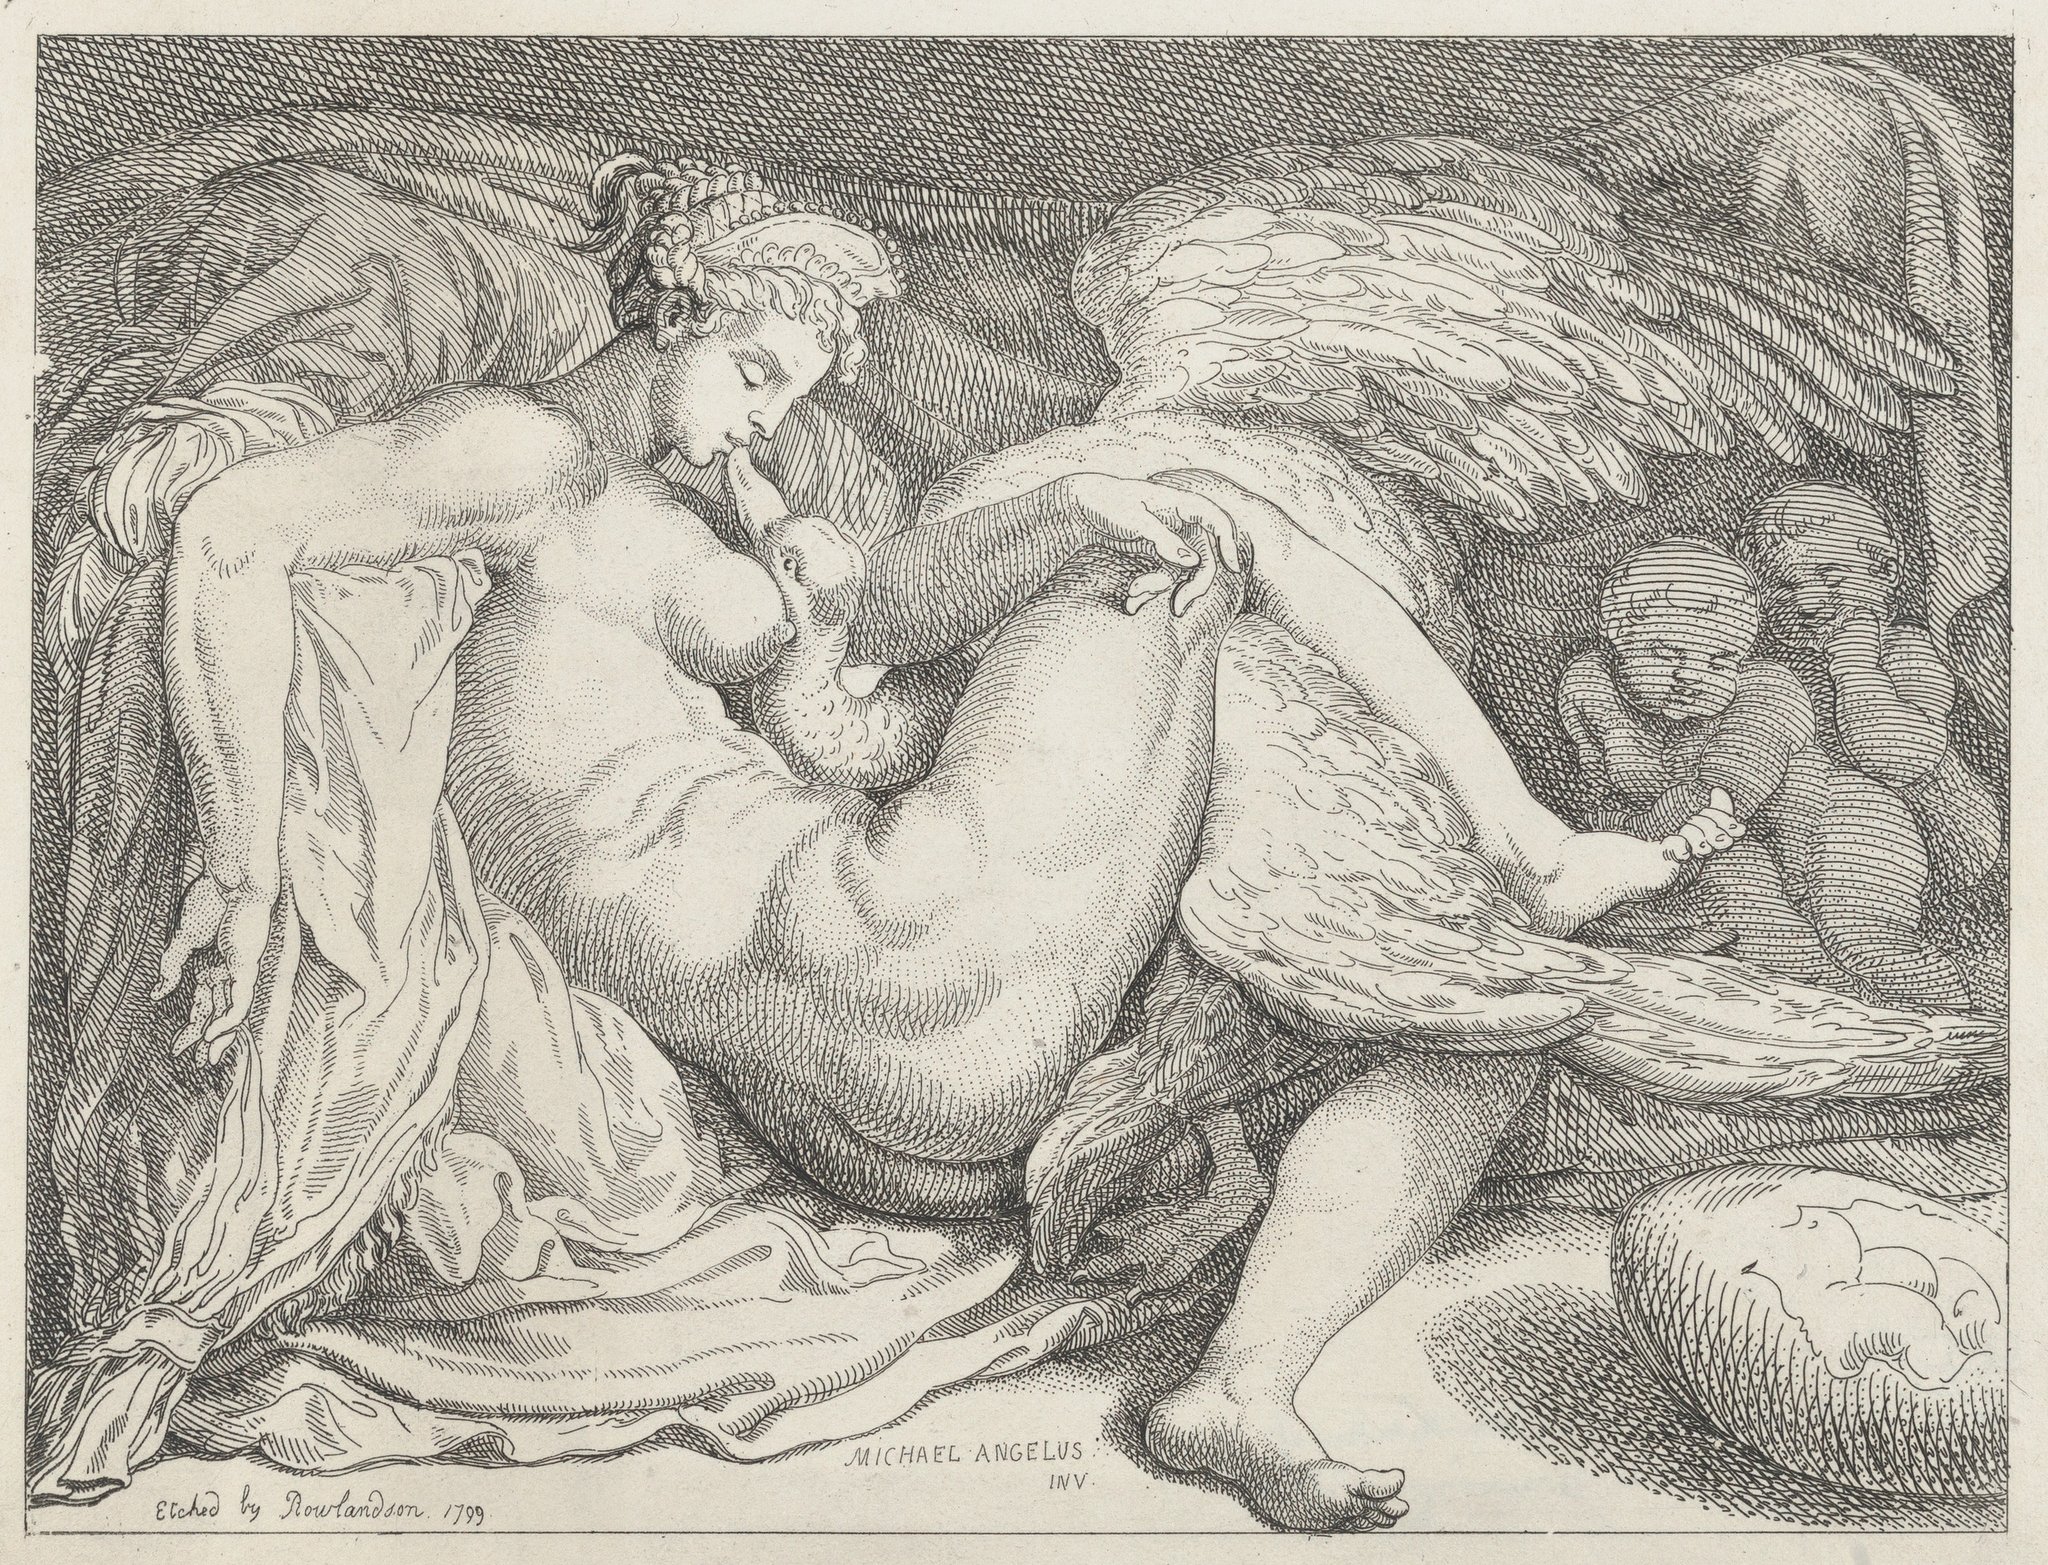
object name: print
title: Leda and the Swan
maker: thomas rowlandson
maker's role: artist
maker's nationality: british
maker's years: 1757-1827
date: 1799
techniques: etching, stippling